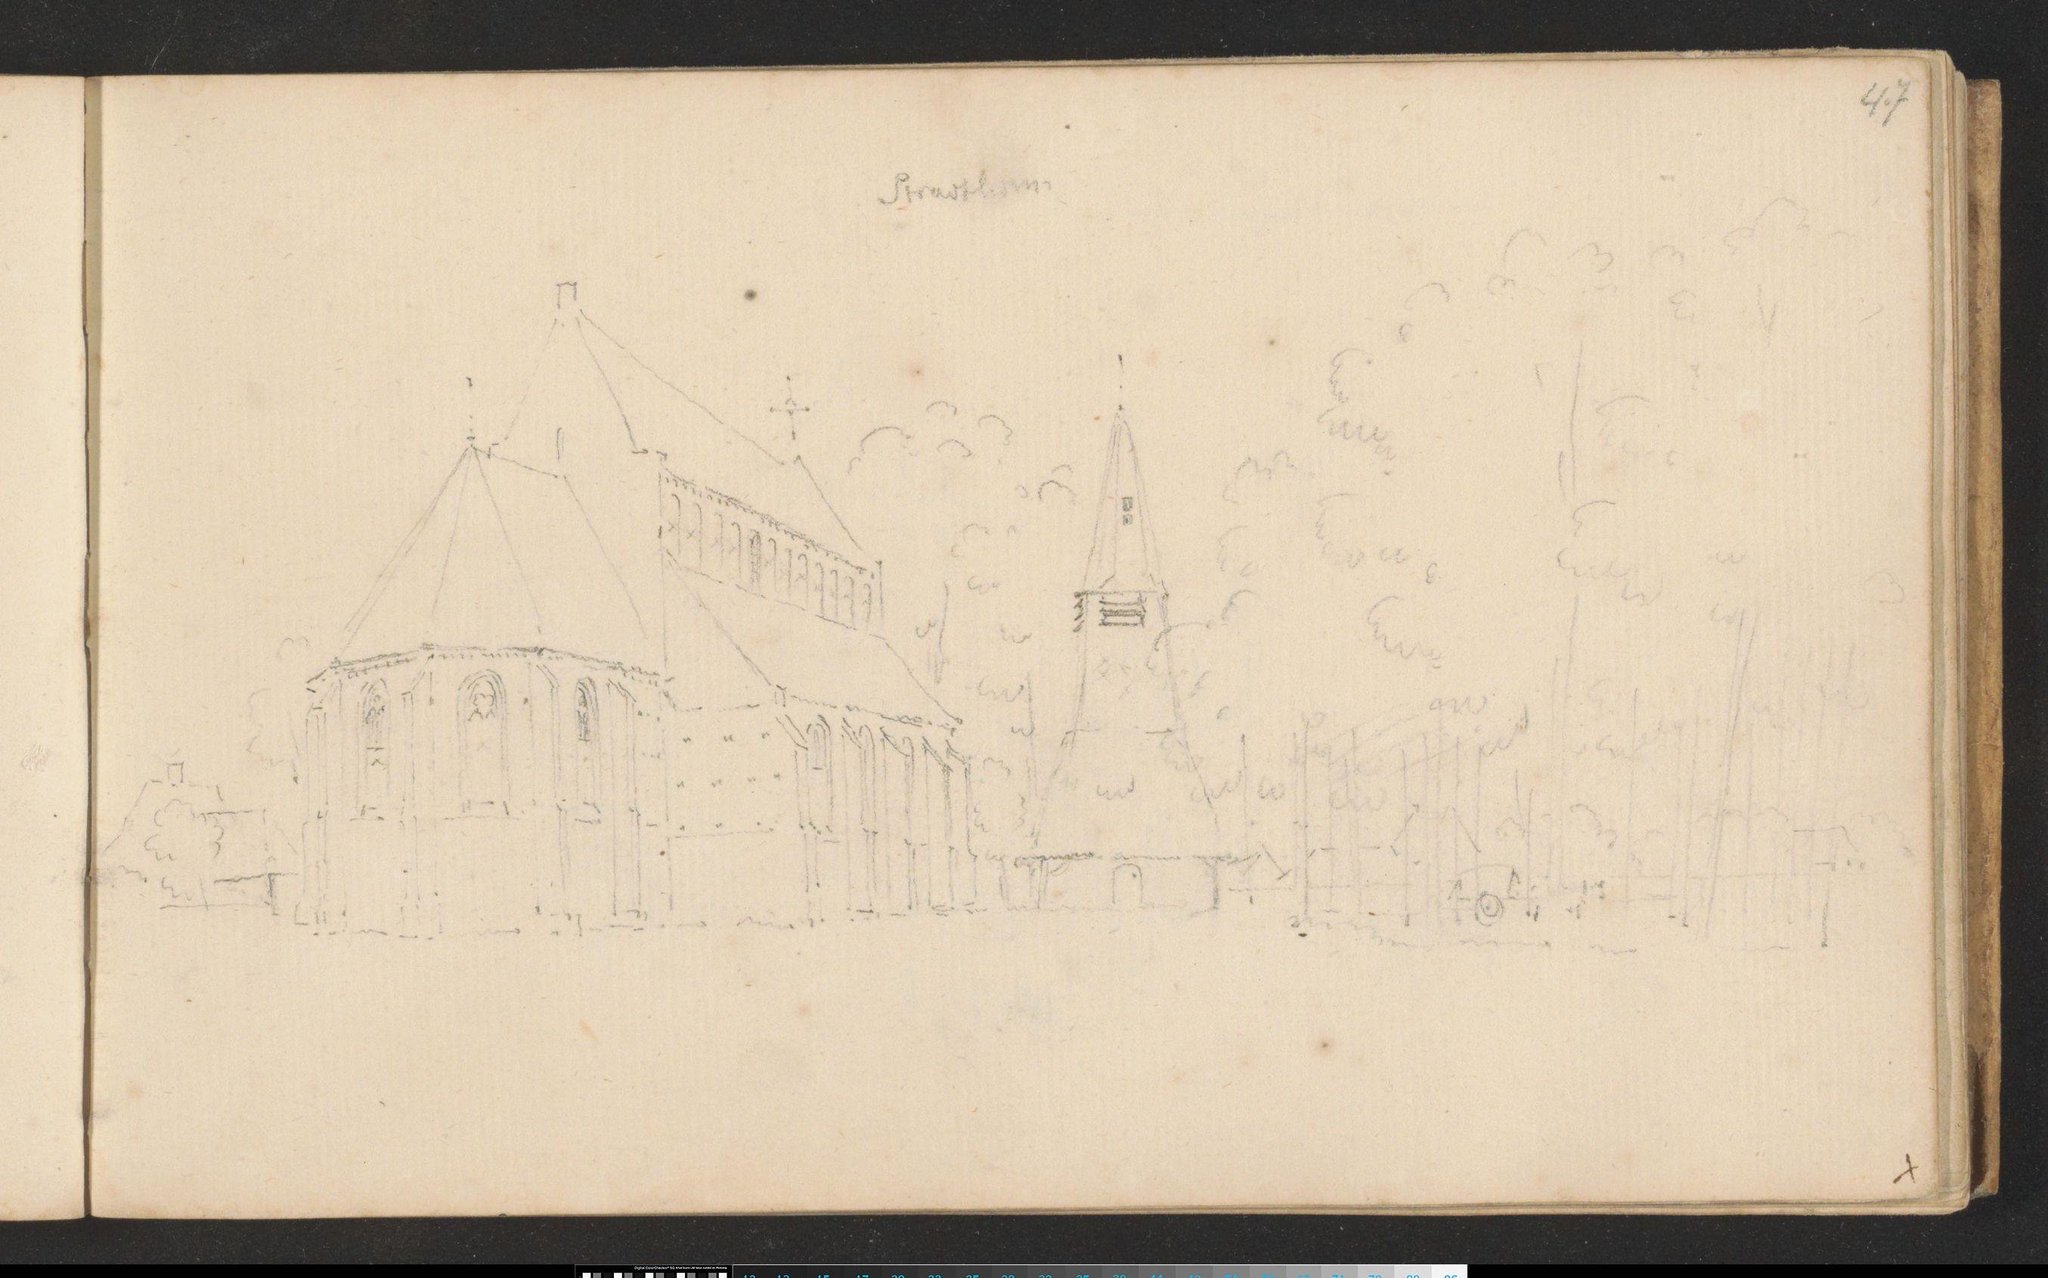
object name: sketchbook leaf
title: Sint-Joriskerk te Stratum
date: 1701-1759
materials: paper, pencil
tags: church (exterior)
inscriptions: annotation: ‘Strath[...]m’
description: Blad 47 recto uit een schetsboek met 65 bladen.